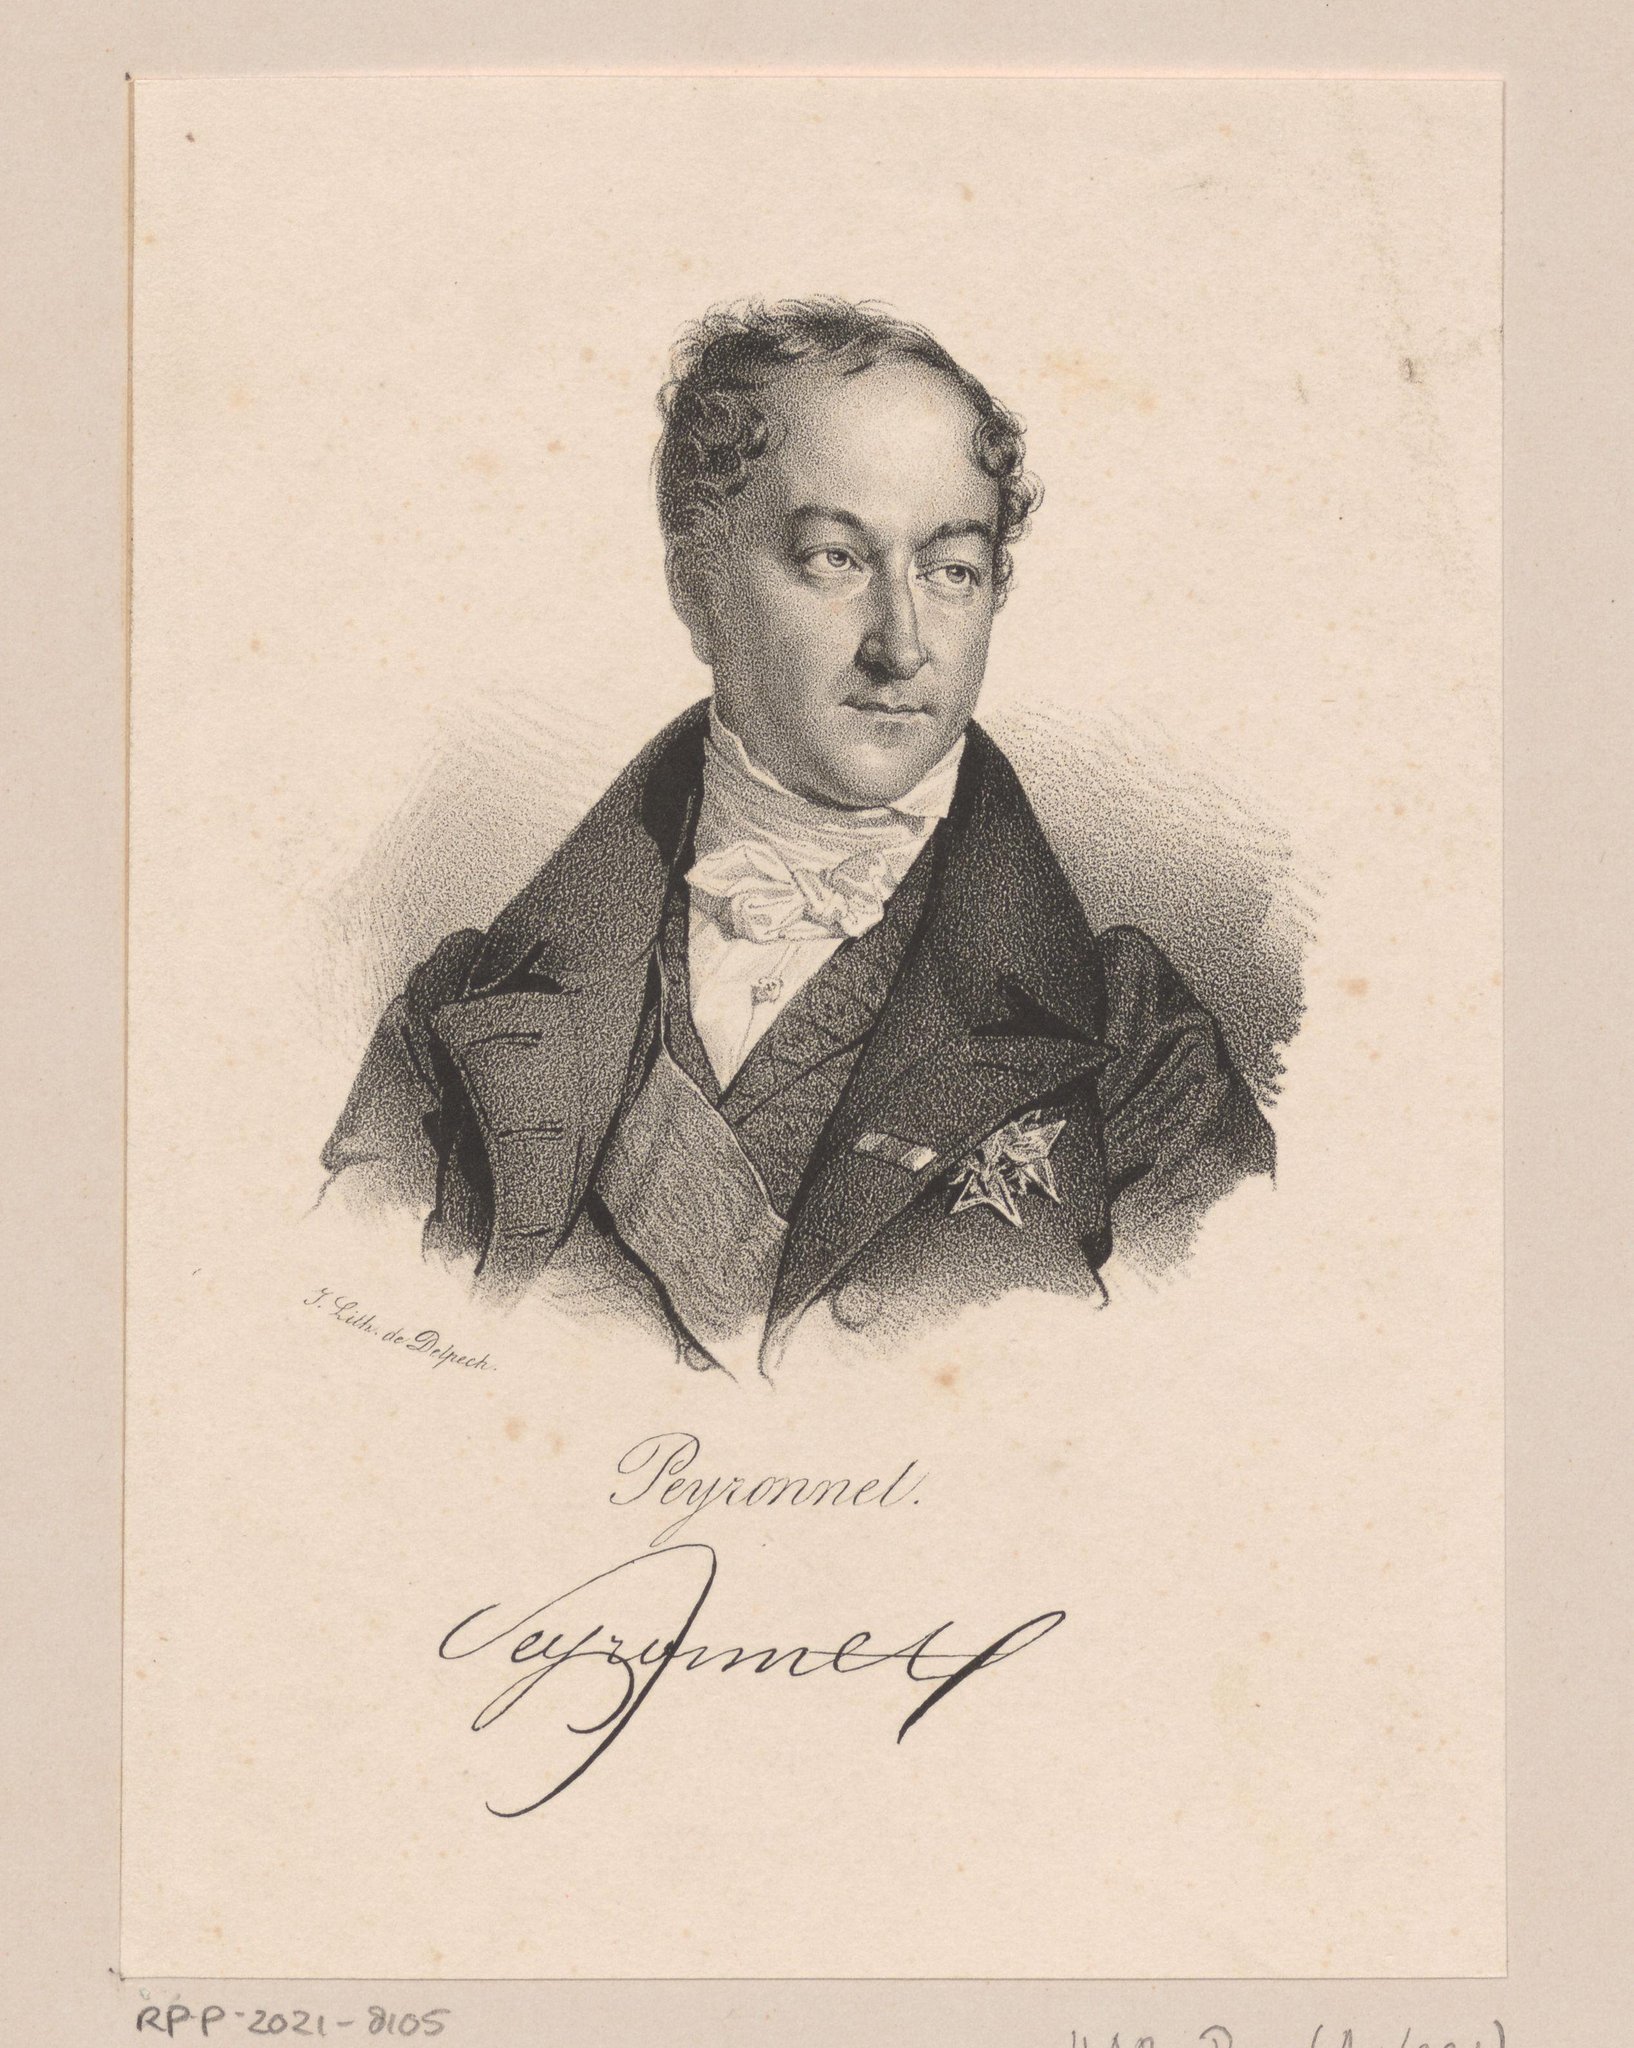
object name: print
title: Portret van Pierre-Denis de Peyronnet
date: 1788-1825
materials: paper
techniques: lithograph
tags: politician, adult man, historical persons